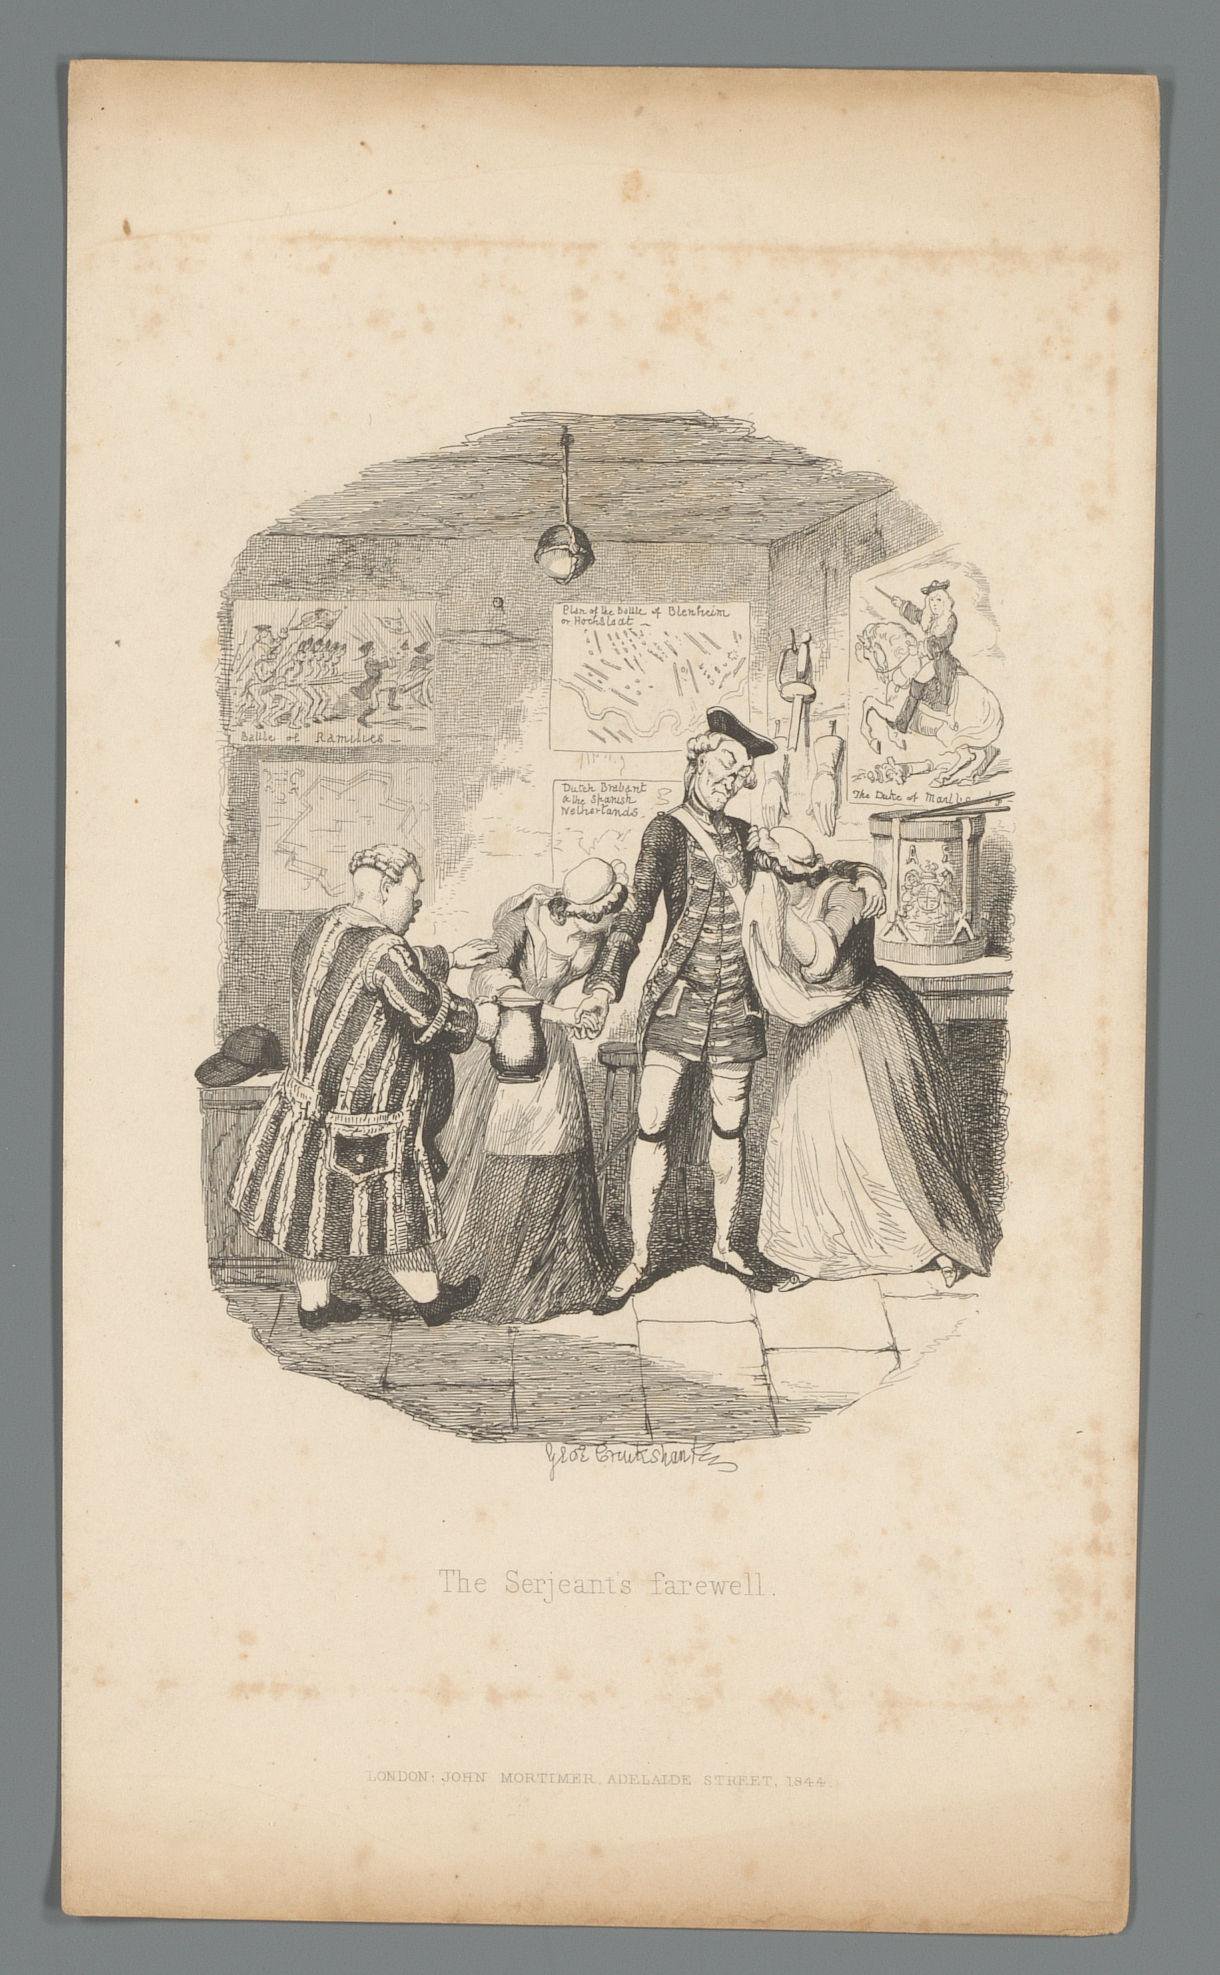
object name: cartoon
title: The Serjeant's farewell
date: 1844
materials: paper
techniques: etching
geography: england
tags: weeping, waving farewell ~ departure on a journey, political caricatures and satires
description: Sergeant Scales neemt afscheid van twee vrouwen, aan de muren prenten, kaarten en objecten uit zijn militaire carrière. Illustratie voor een uitgave van "St James's, or the Court of Queen Anne" van Ainsworth, 1844.